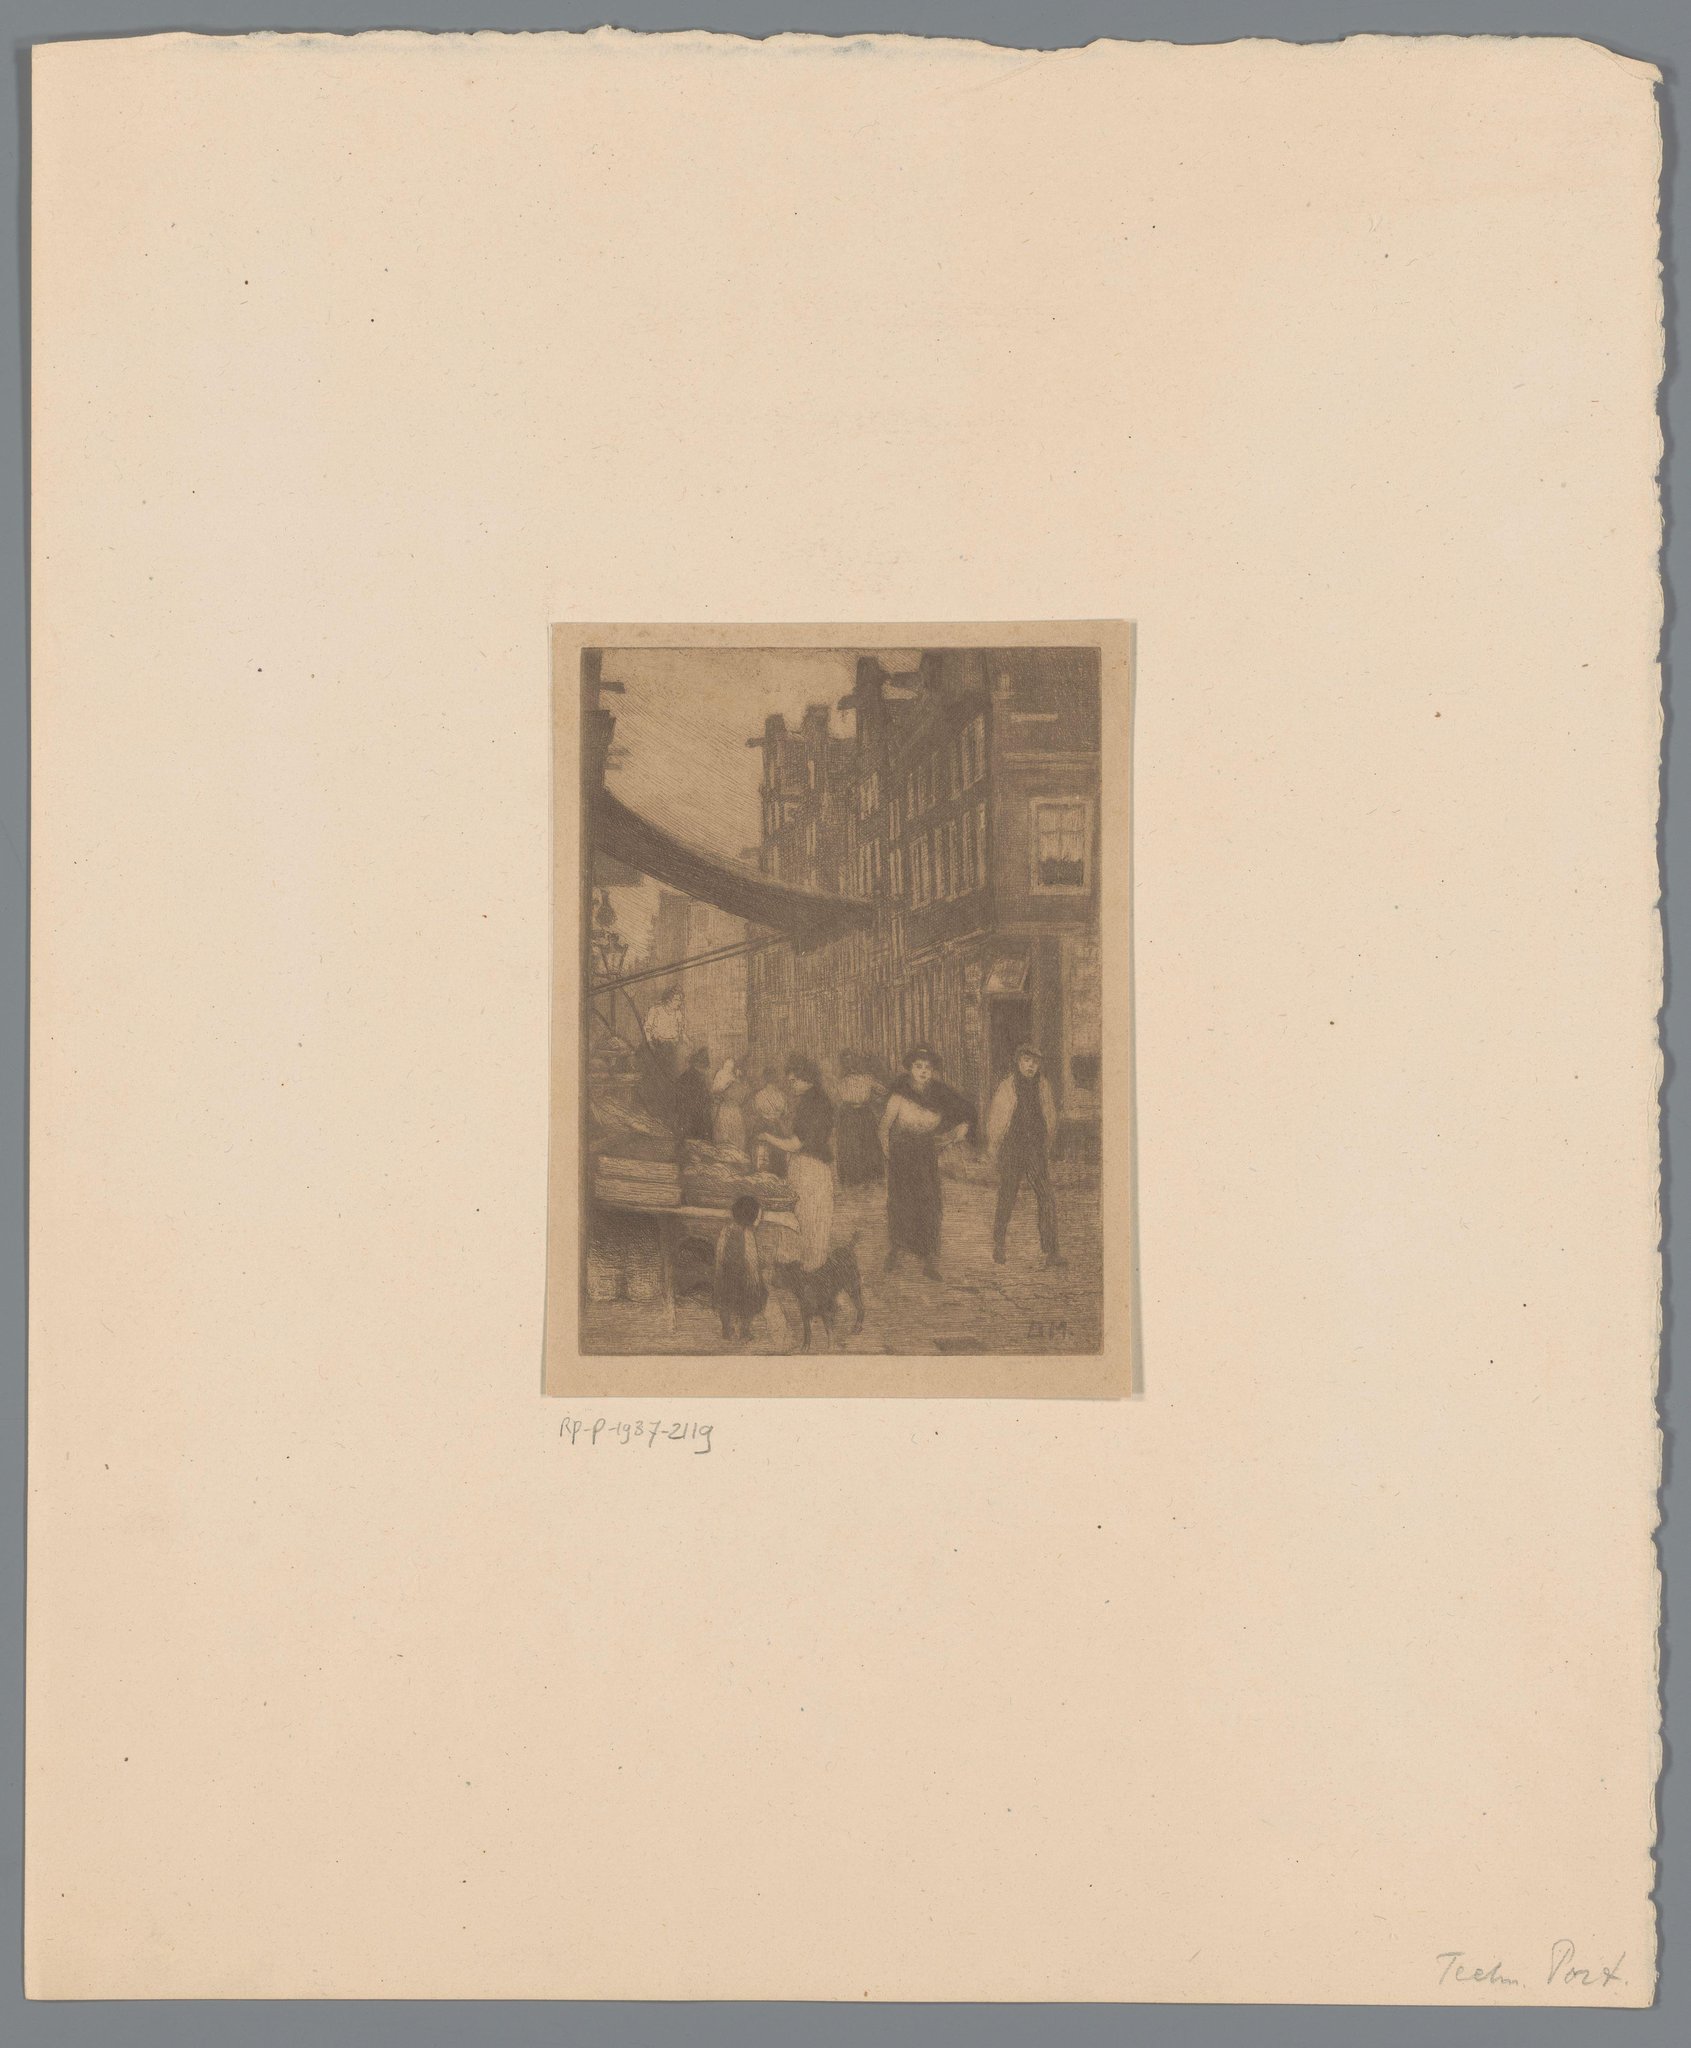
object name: print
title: Marktkraam in een straat in een Hollandse stad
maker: Anonymous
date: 1850-1900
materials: paper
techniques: etching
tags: stall, booth (~ market), street (+ city(-scape) with figures, staffage)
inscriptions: collector's mark: Lugt 2228, inscription: ‘aanw 1924’, collector's mark: Lugt 2760